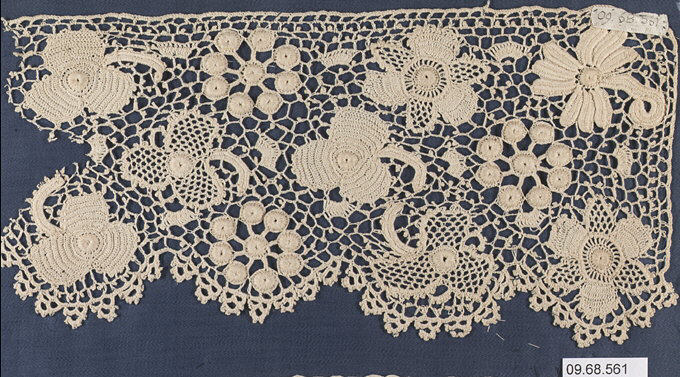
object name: specimen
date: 1801-1900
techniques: crochet